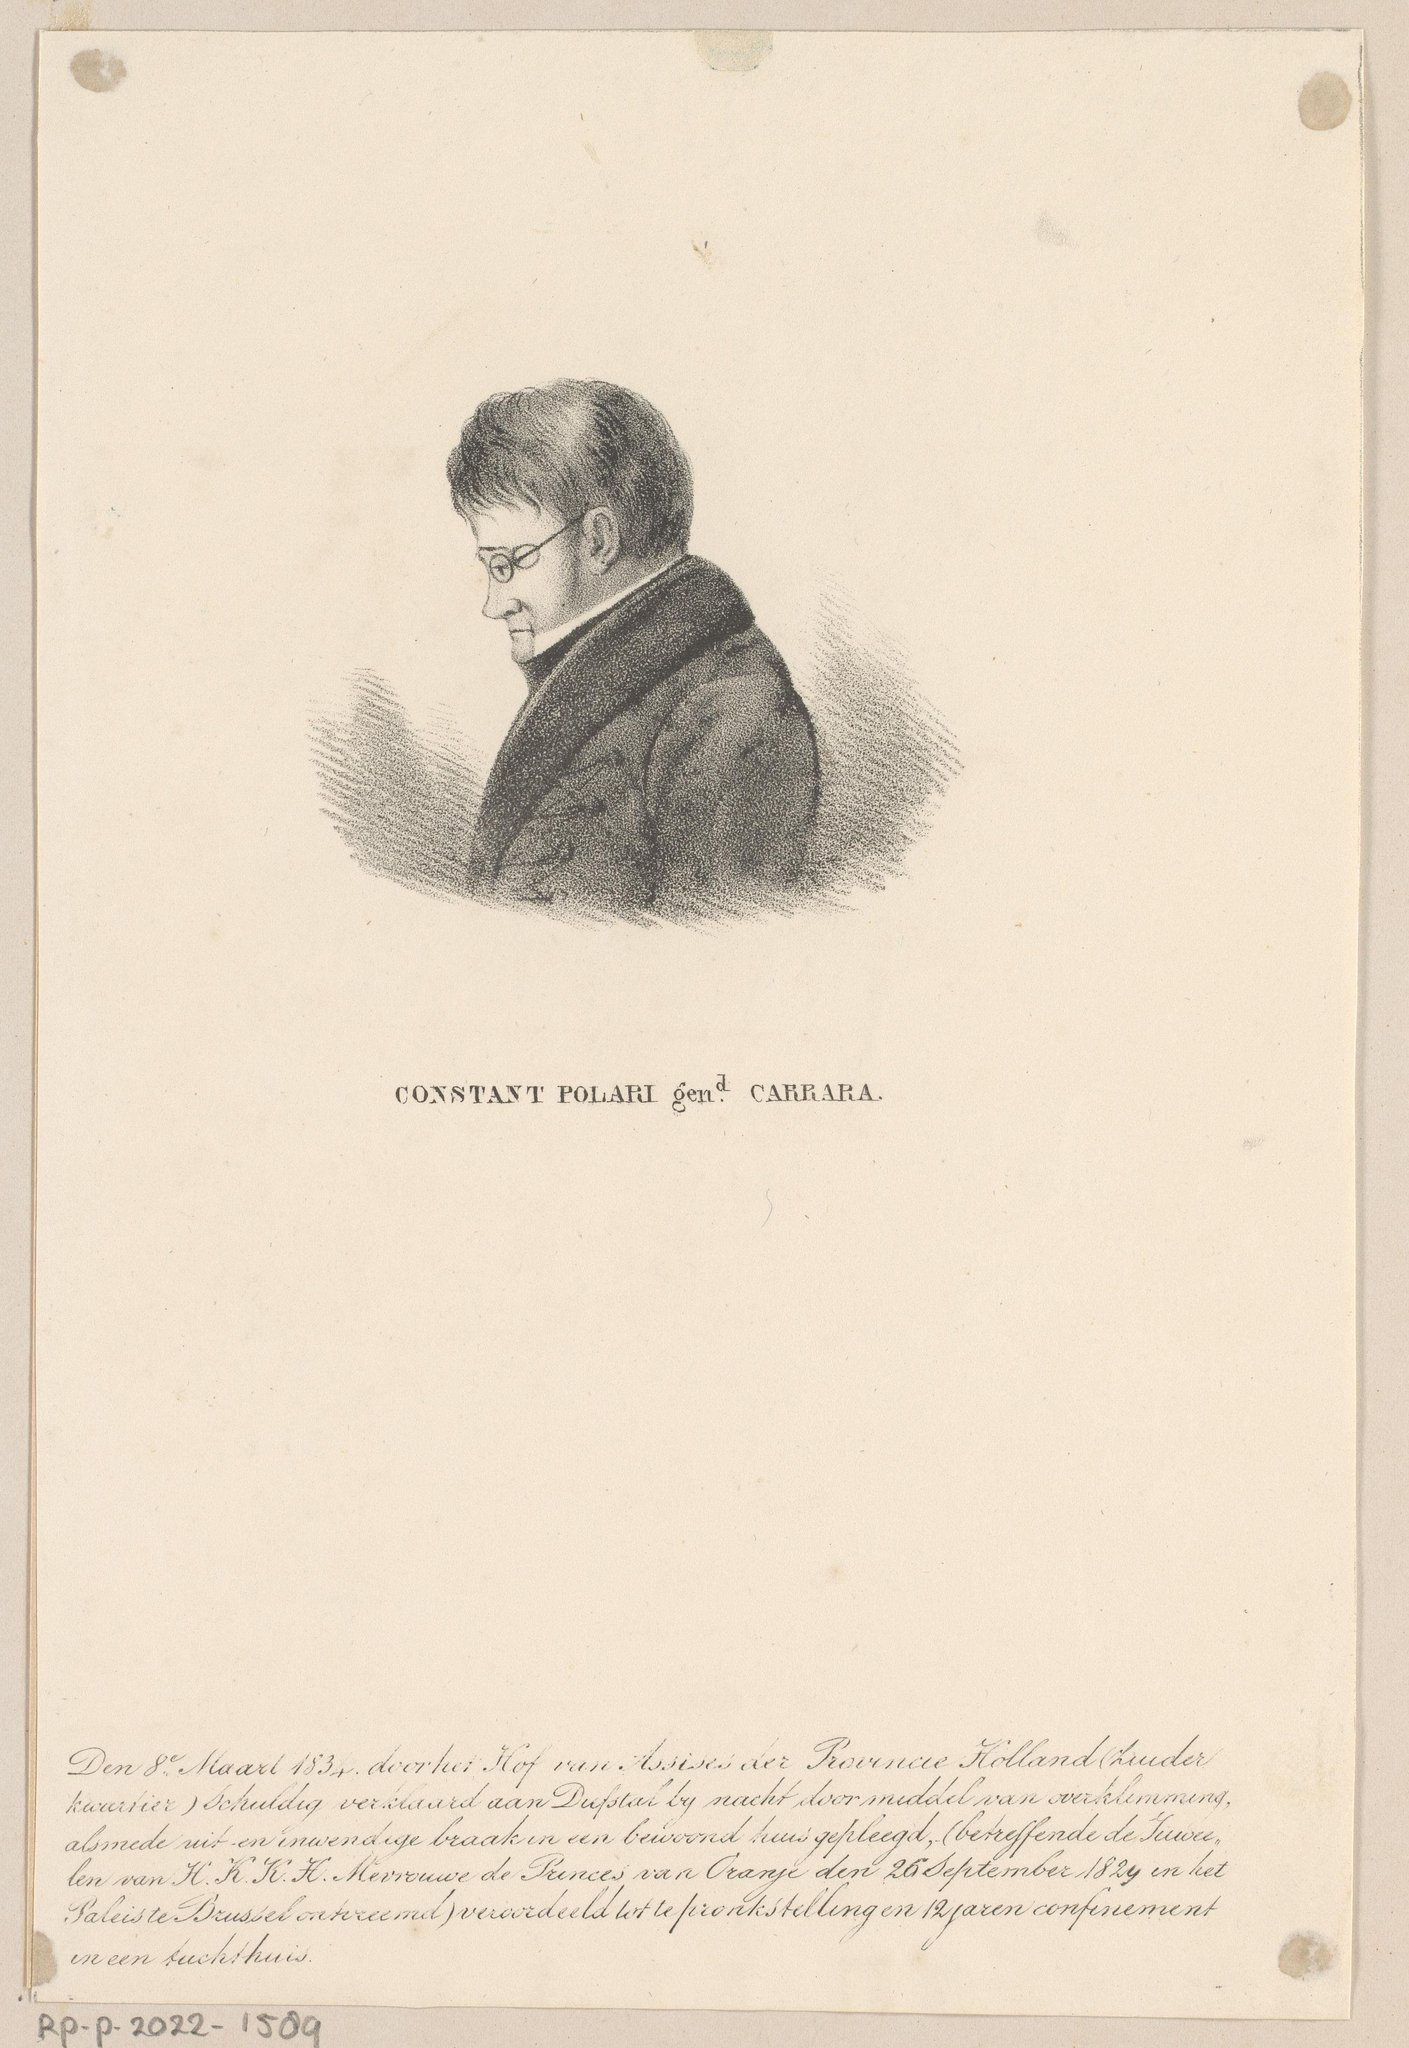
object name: print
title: Portret van Constant Polari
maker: Anonymous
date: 1834-1850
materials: paper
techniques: lithograph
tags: eyeglasses, spectacles, historical persons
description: Met zesregelig onderschrift in het Nederlands.